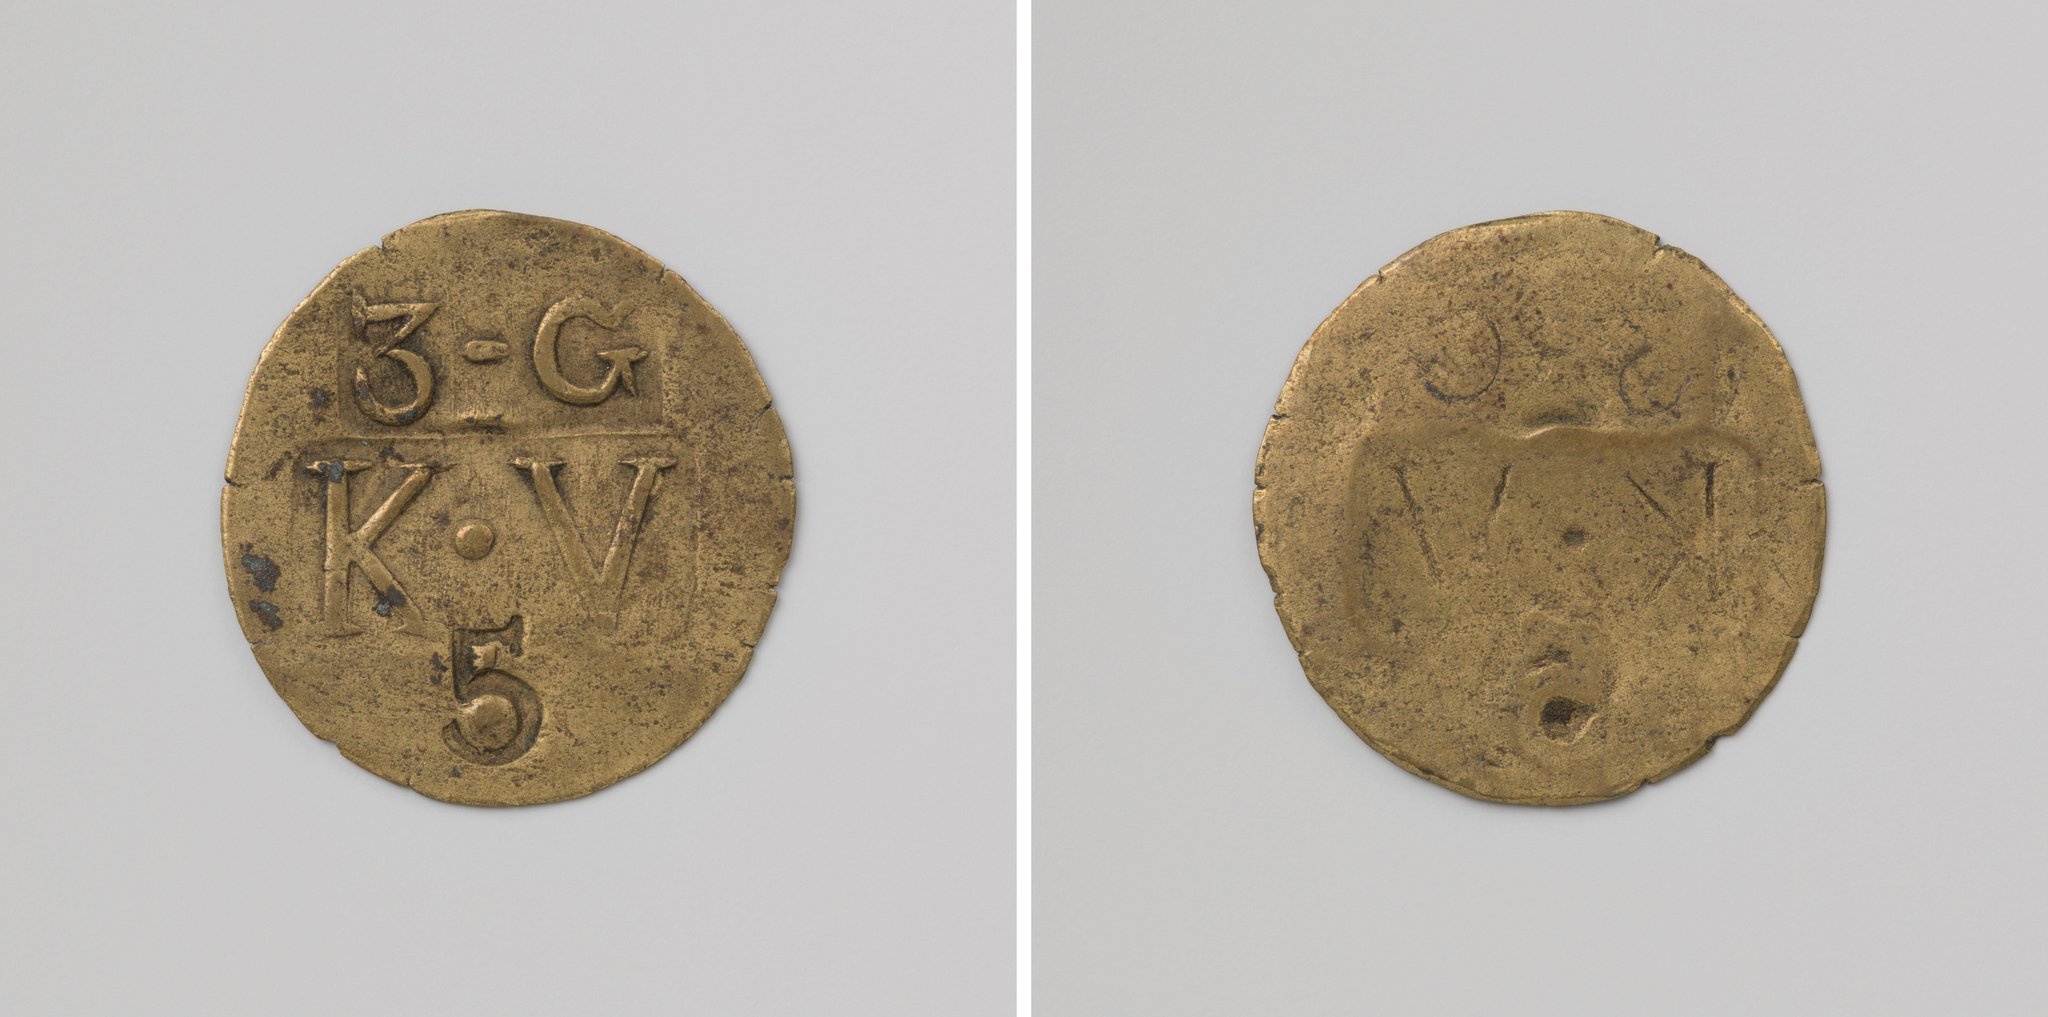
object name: monetary token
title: Derde gesticht van de kolonie Veenhuizen, huismunt geslagen op last van de Maatschappij van Weldadigheid ter waarde van vijf cent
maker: Anonymous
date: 1818-1859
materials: brass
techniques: striking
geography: netherlands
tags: maatschappij van weldadigheid, veenhuizen